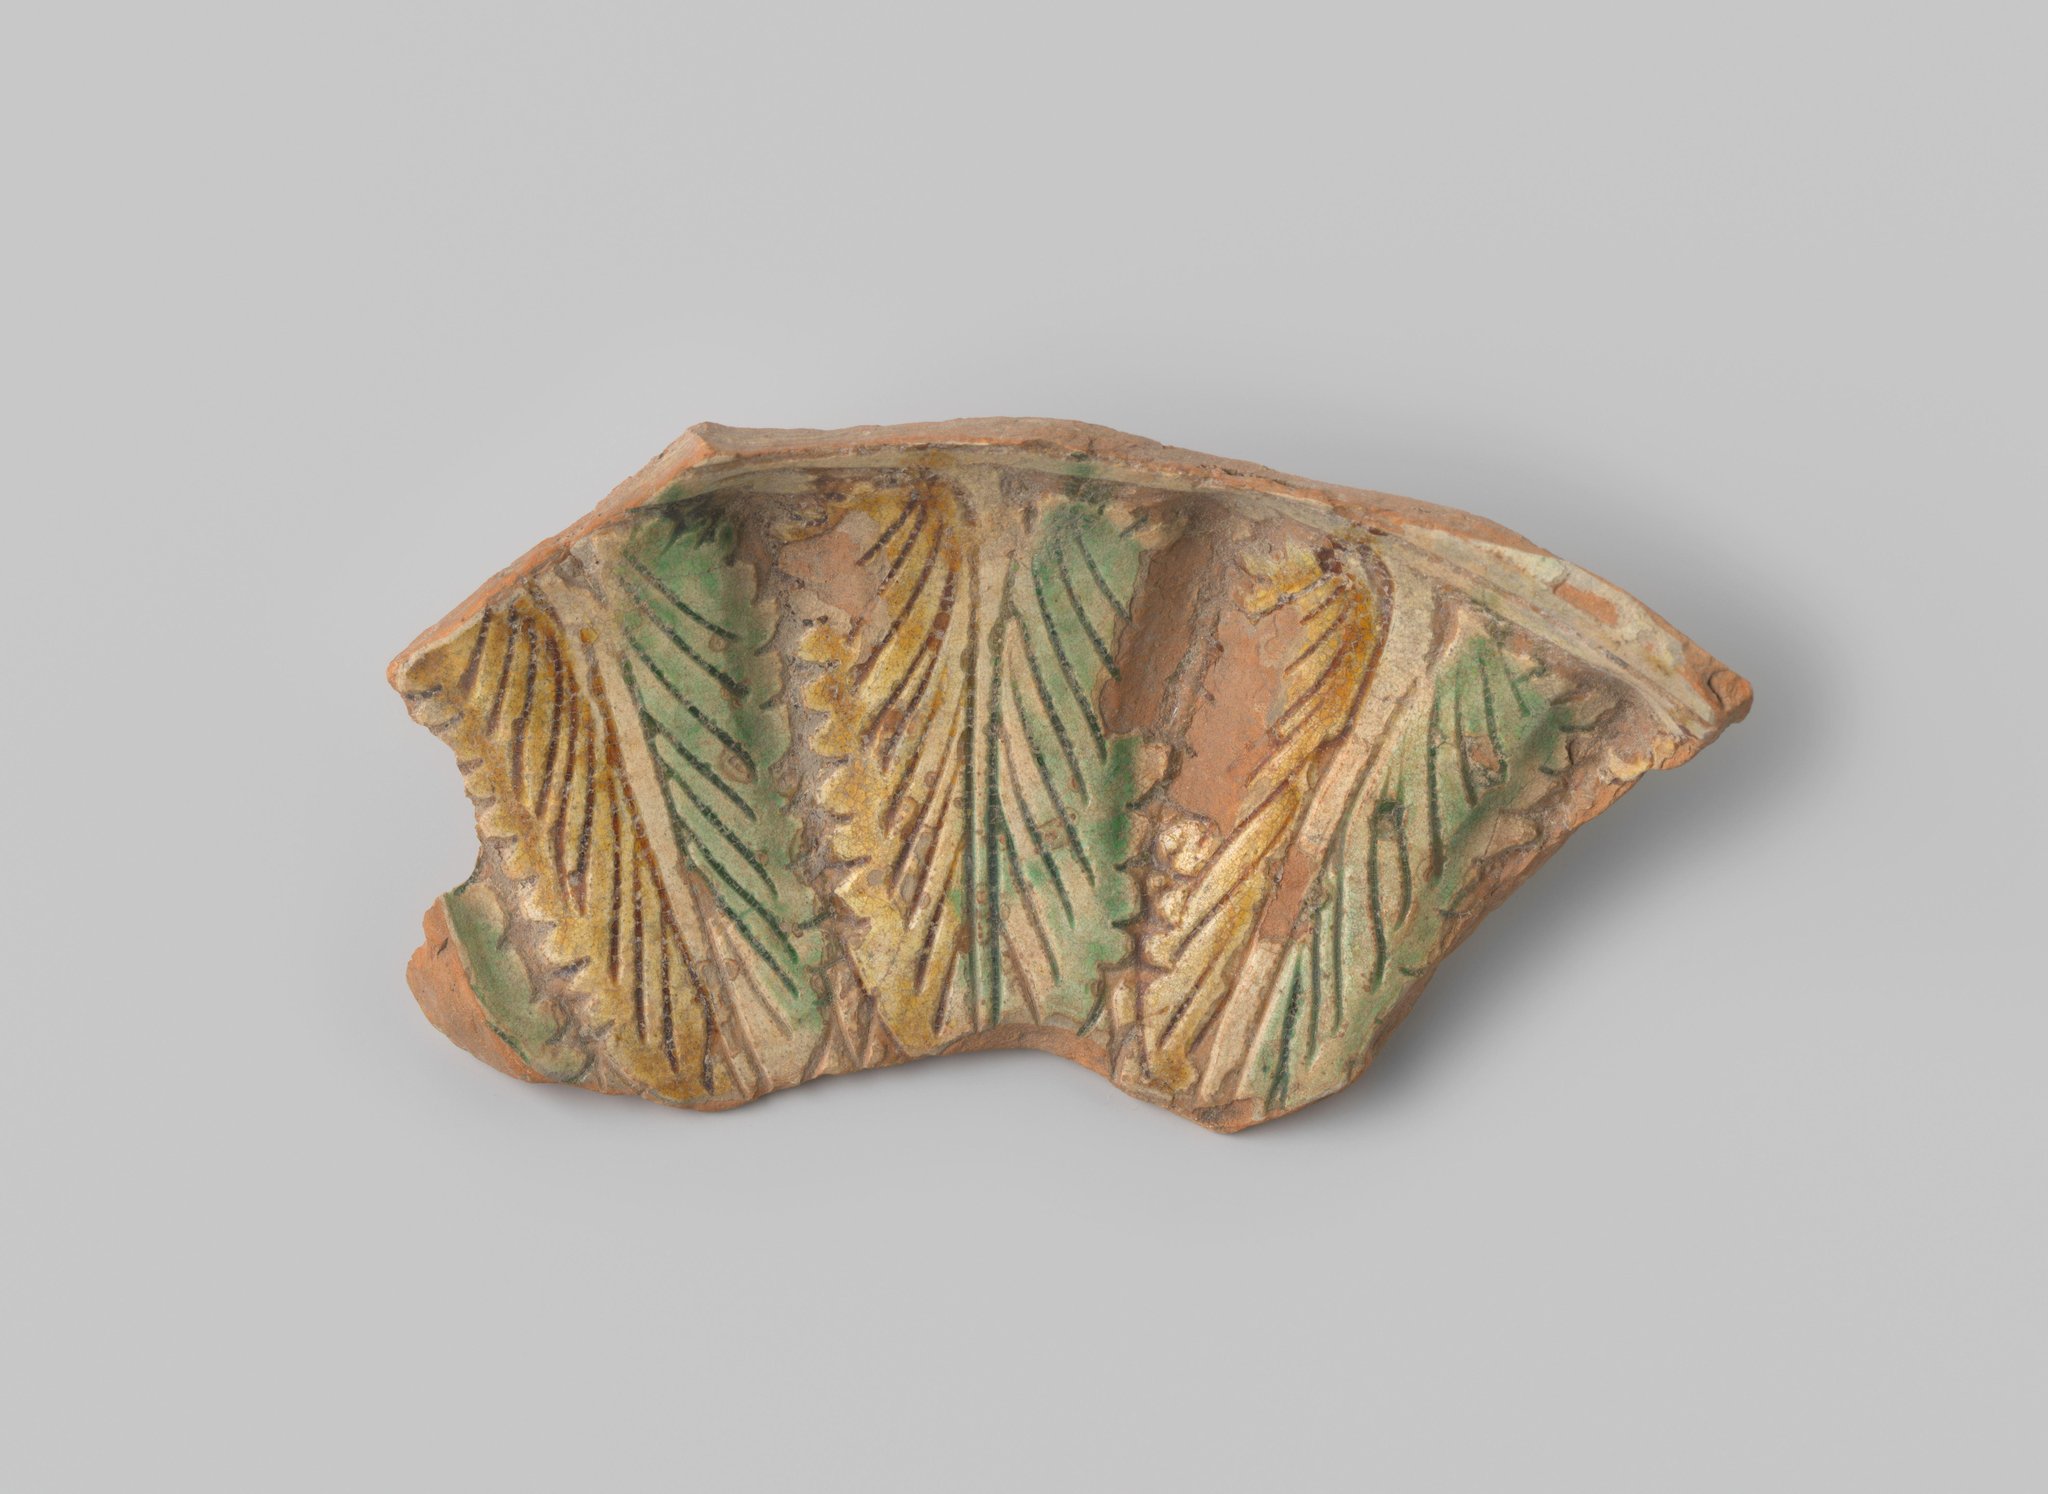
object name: sherd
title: Schotelscherf van roodbakkend aardewerk, aan de voorzijde voorzien van een bladmotief in sgrafitto-techniek met witte, gele en groene glazuur, aan de achterzijde ongeglazuurd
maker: Anonymous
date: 1200-1899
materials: earthenware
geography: italy